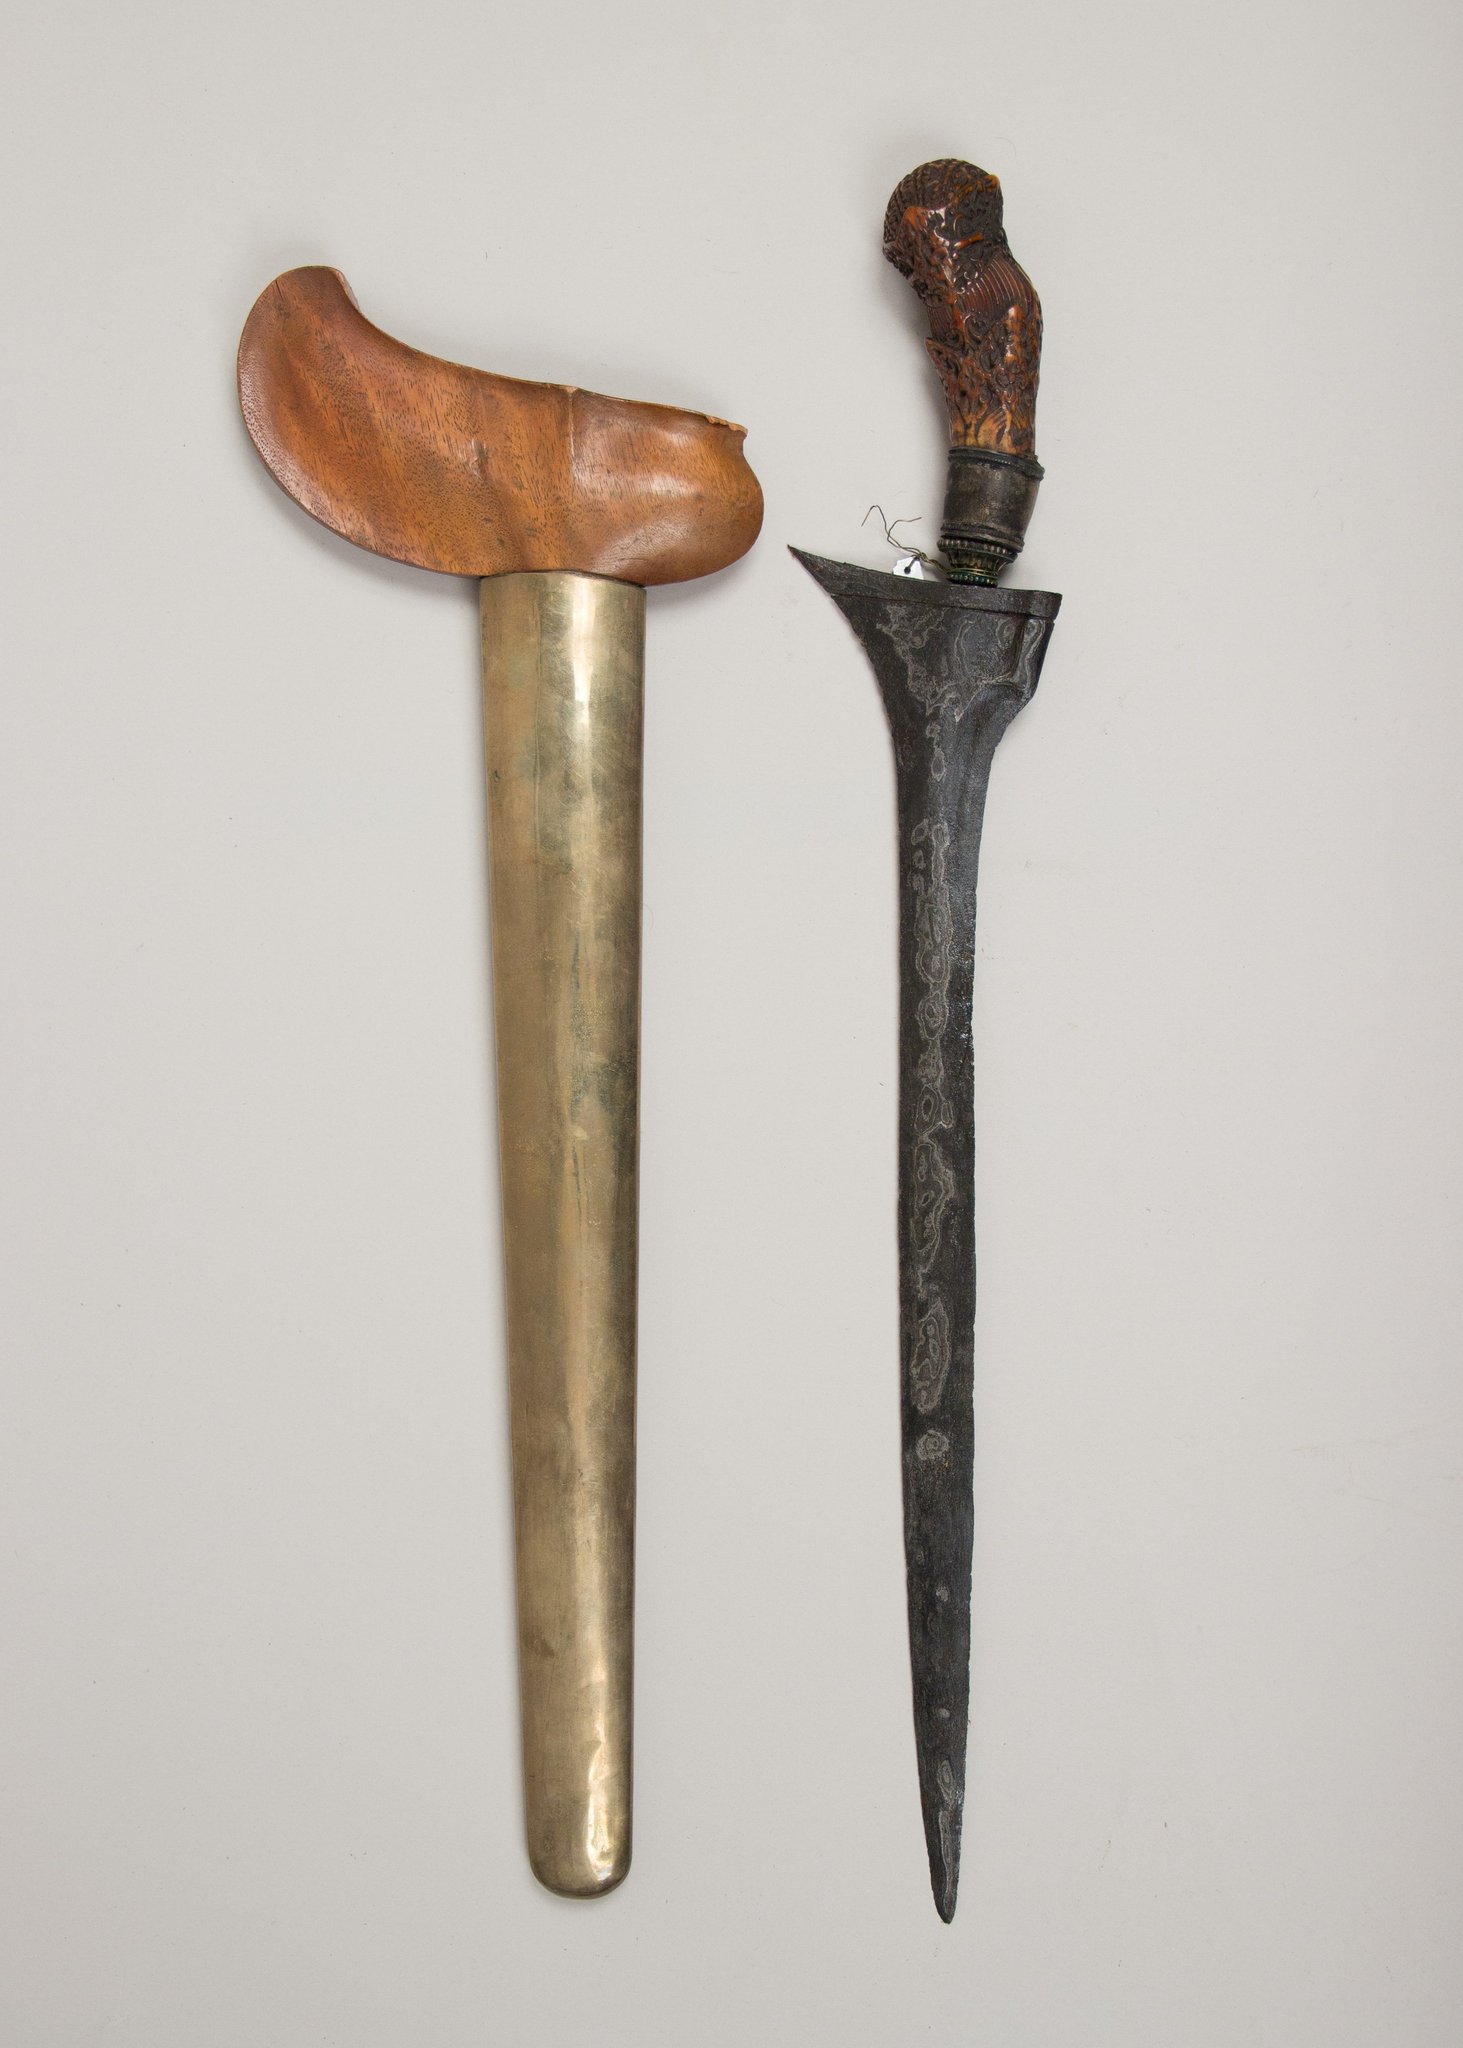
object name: kris with sheath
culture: javanese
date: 1501-1900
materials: brass, horn, shell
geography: indonesia